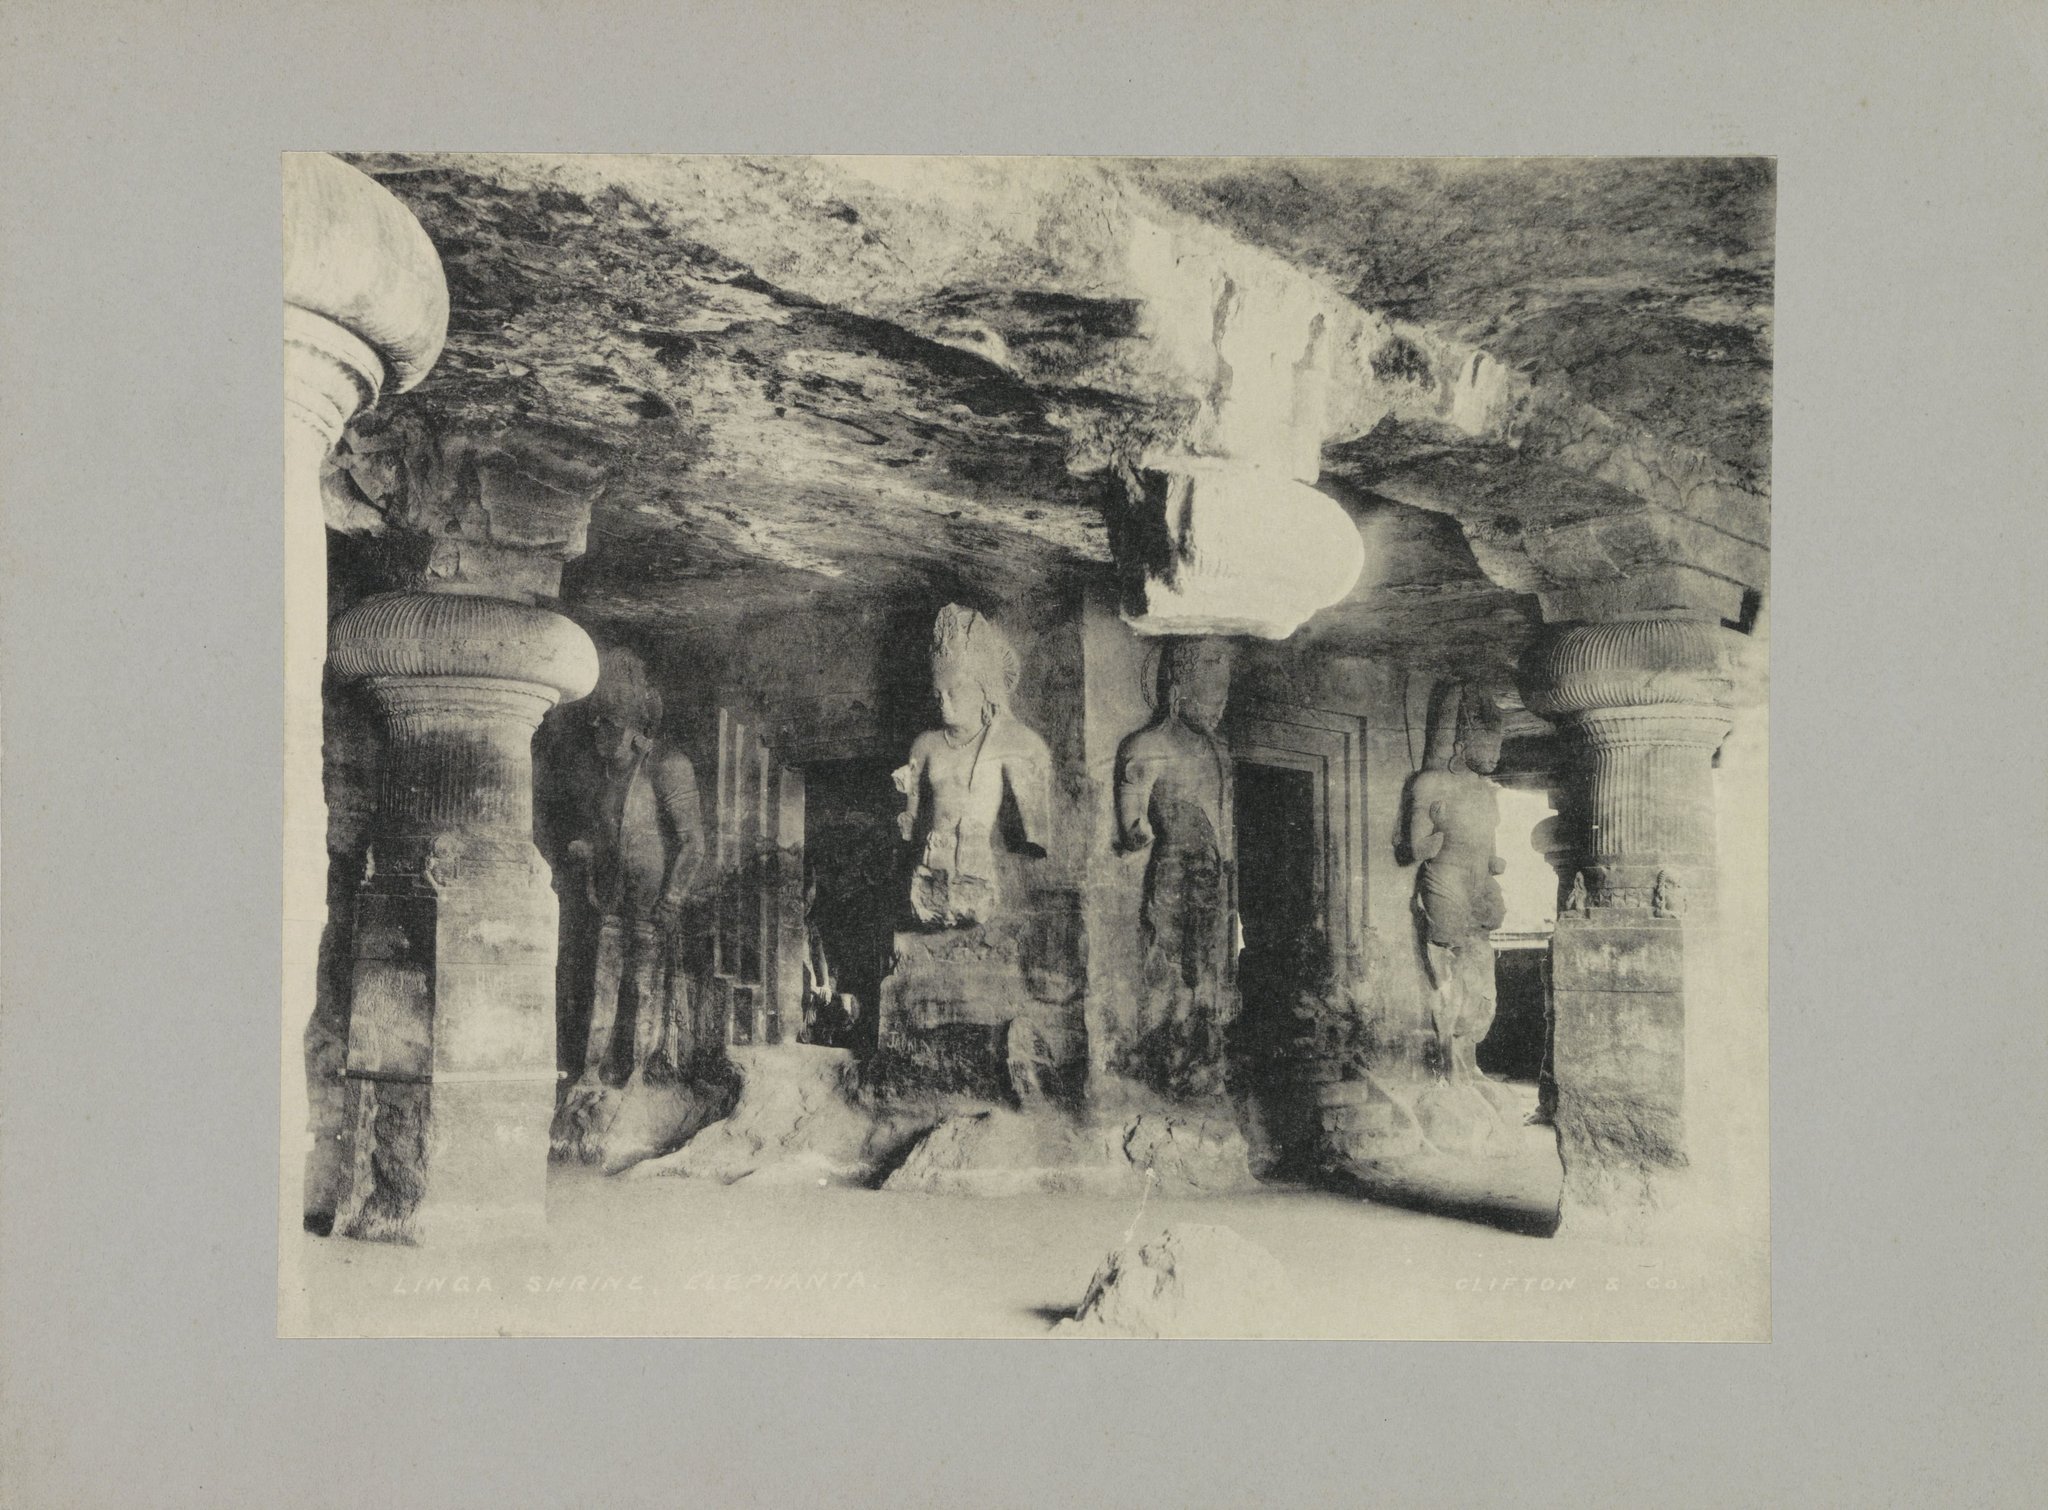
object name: photomechanical print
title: Linga shrine in the Elephanta Caves near Mumbai, Maharashtra, India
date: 1895-1915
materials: cardboard, paper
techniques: photograph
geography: mumbai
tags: mumbai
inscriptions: annotation: ‘74. Elefanta.’, title: ‘LINGA SHRINE, ELEPHANTA.’, signature: ‘CLIFTON & CO.’